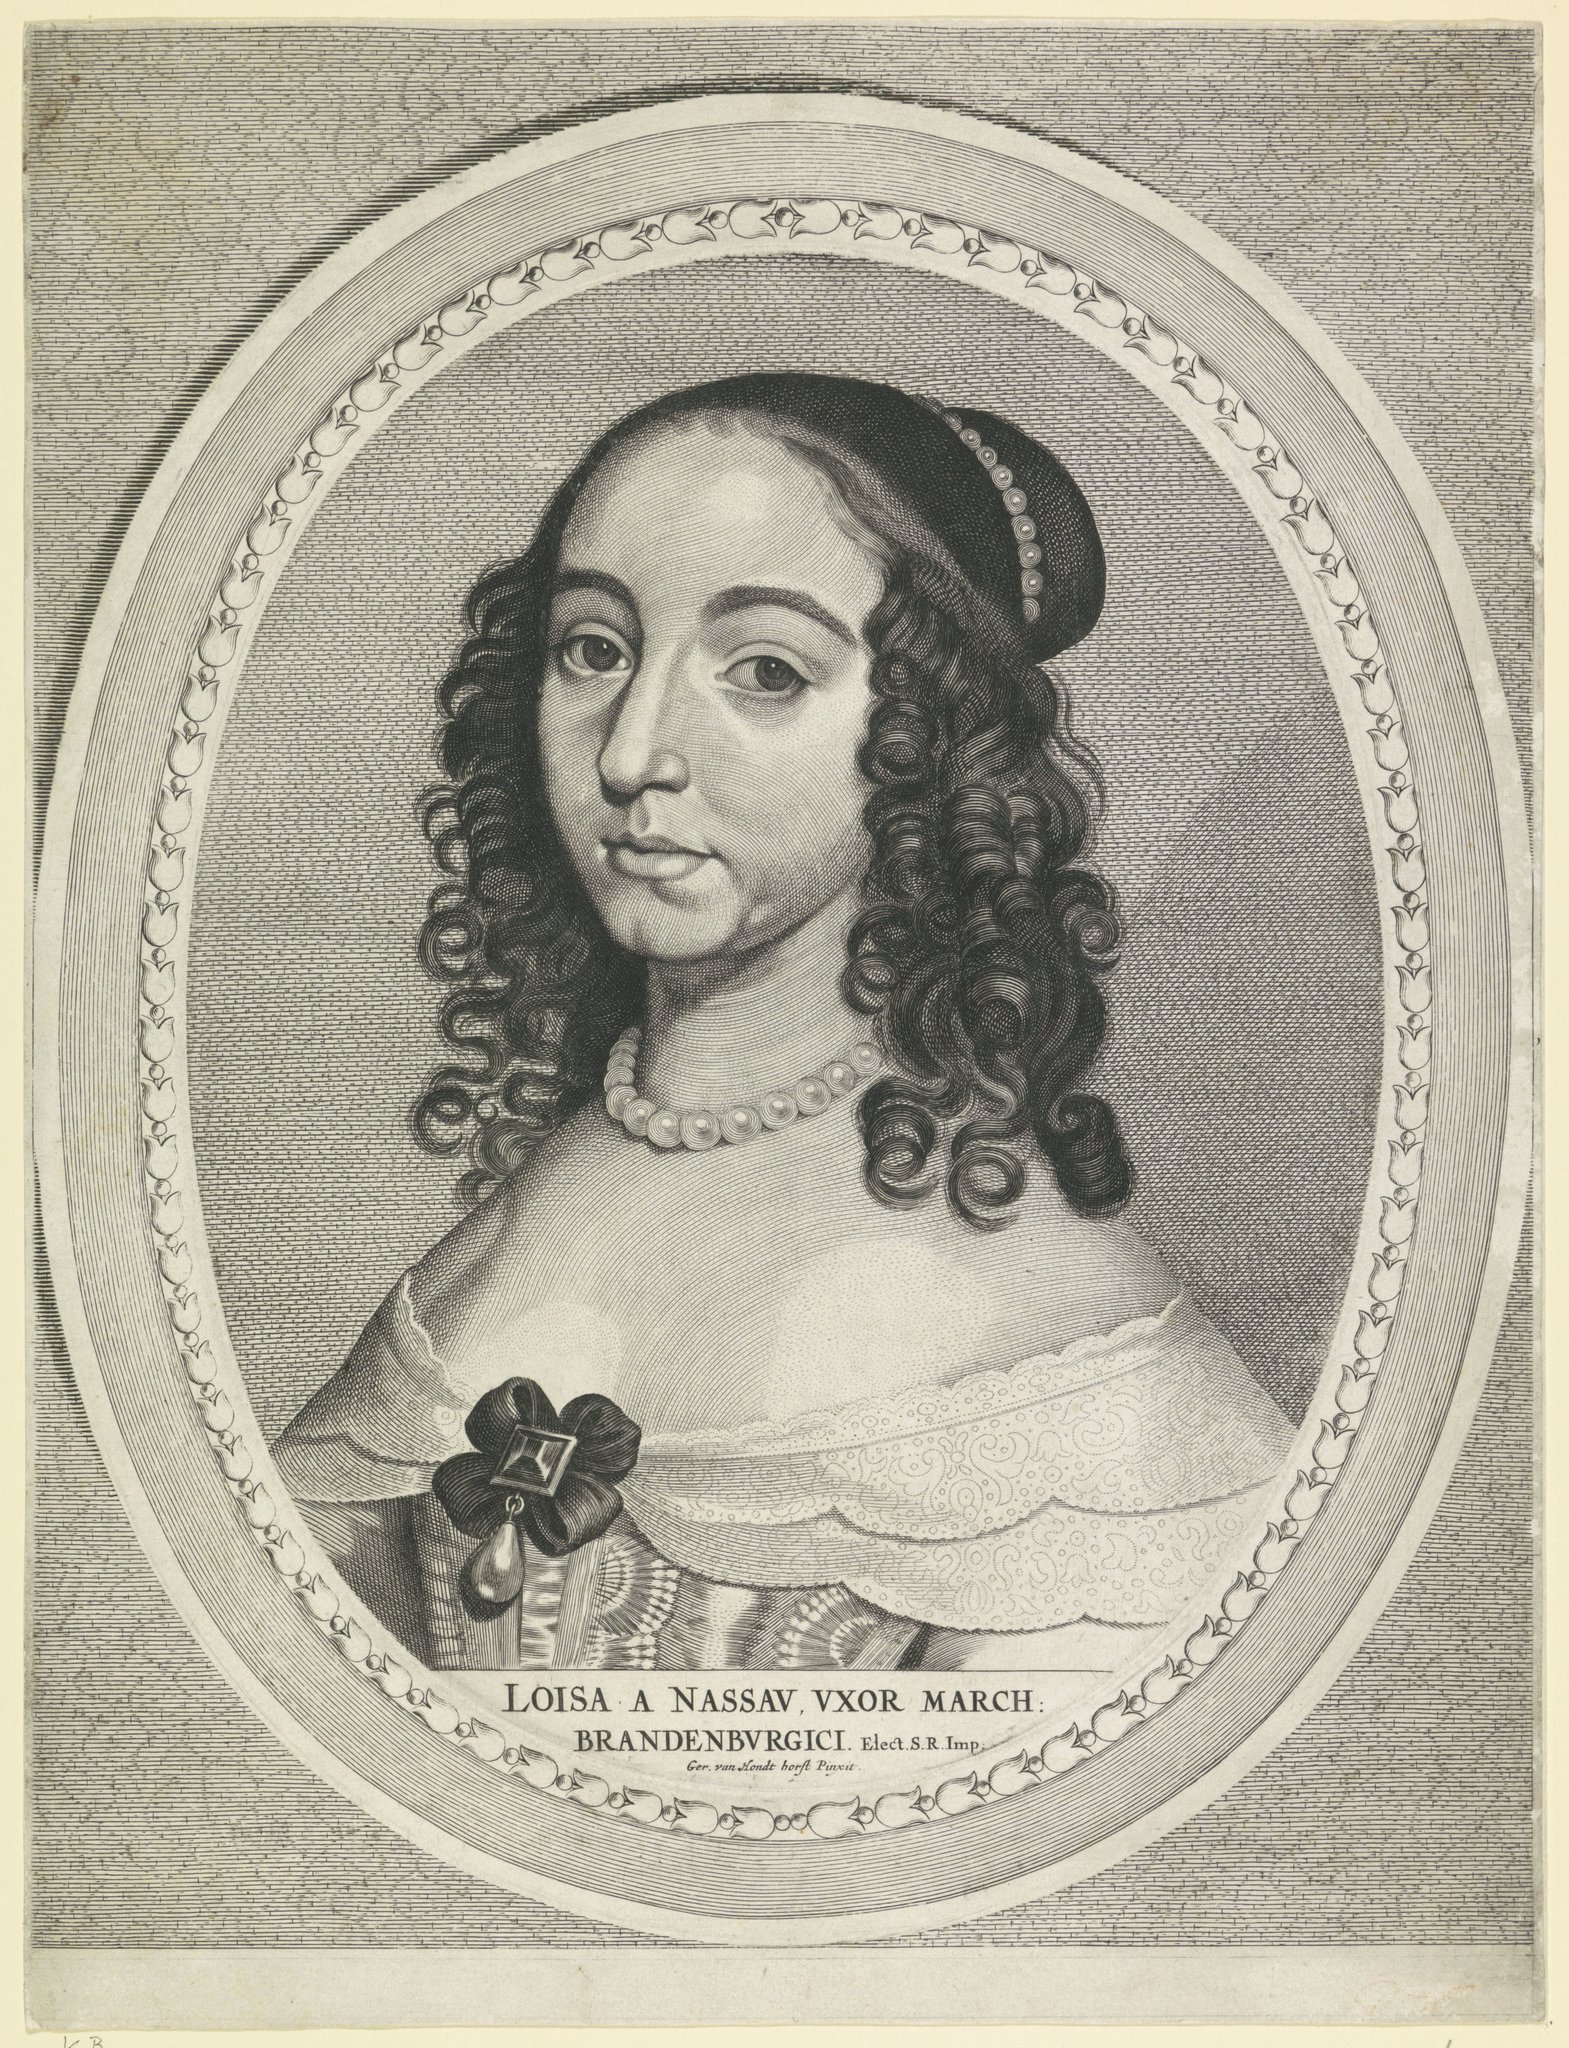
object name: print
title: Portret van Louise Henriëtte, prinses van Oranje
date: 1649-1688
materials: paper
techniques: engraving, etching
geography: amsterdam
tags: the hague, berlin, louise henriëtte (prinses van oranje)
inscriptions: collector's mark: Lugt 240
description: De hier vermelde titel verwijst naar de hoogst verkregen titel van de geportretteerde, niet per se naar de titel die de geportretteerde op deze voorstelling draagt.